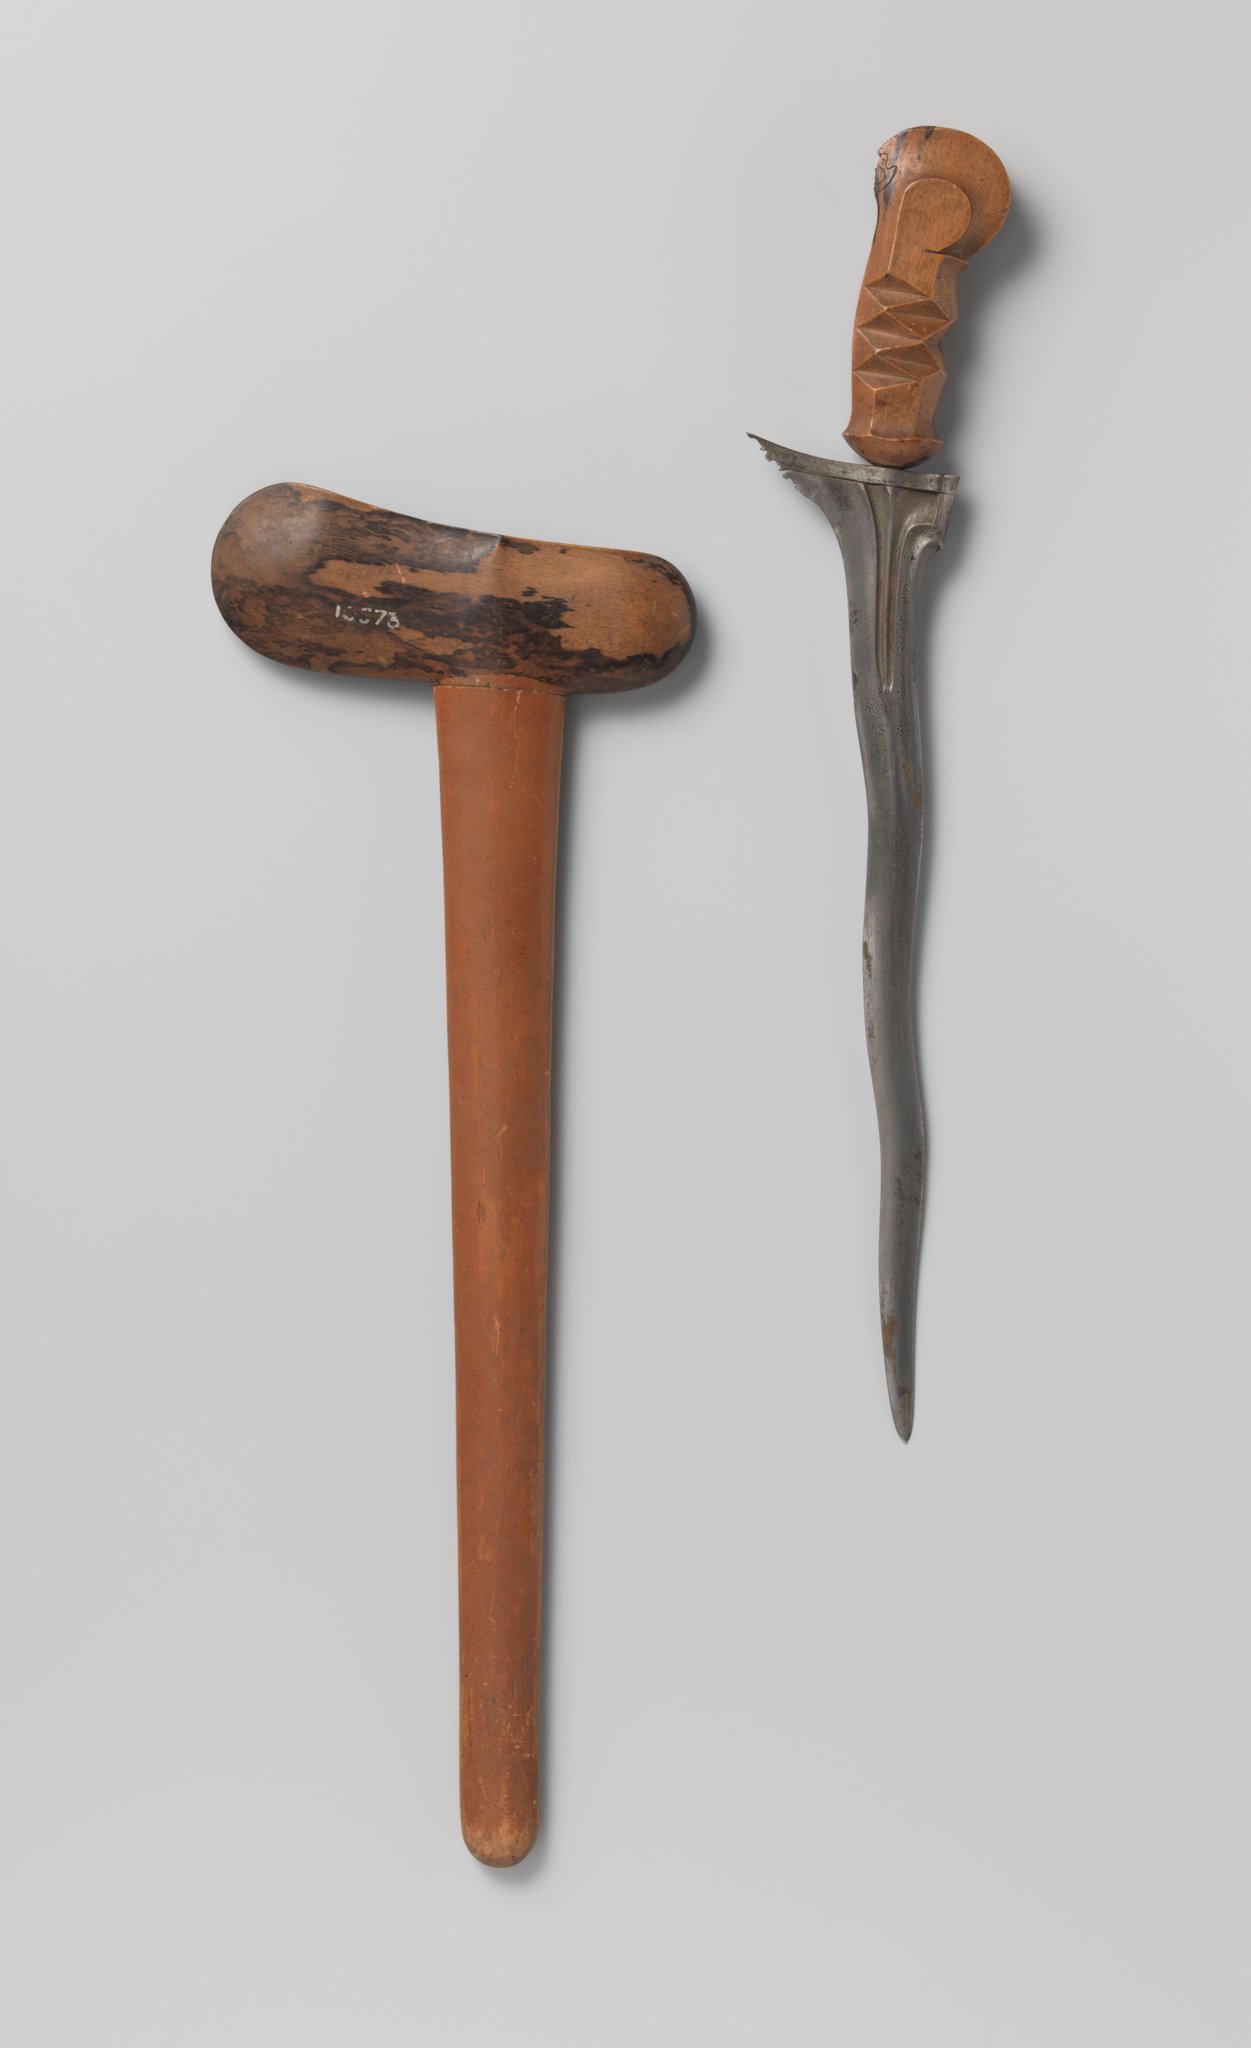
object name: kris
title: Kris van Bali met schede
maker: Anonymous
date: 1800-1899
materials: iron, wood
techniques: metalworking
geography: bali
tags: lombok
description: Kris van Bali met het staal van het lemmet gedamaskeerd als vlammen, met aan een zijde geel geverfde schede. Buitgemaakt op de expeditie van Lombok in 1894.